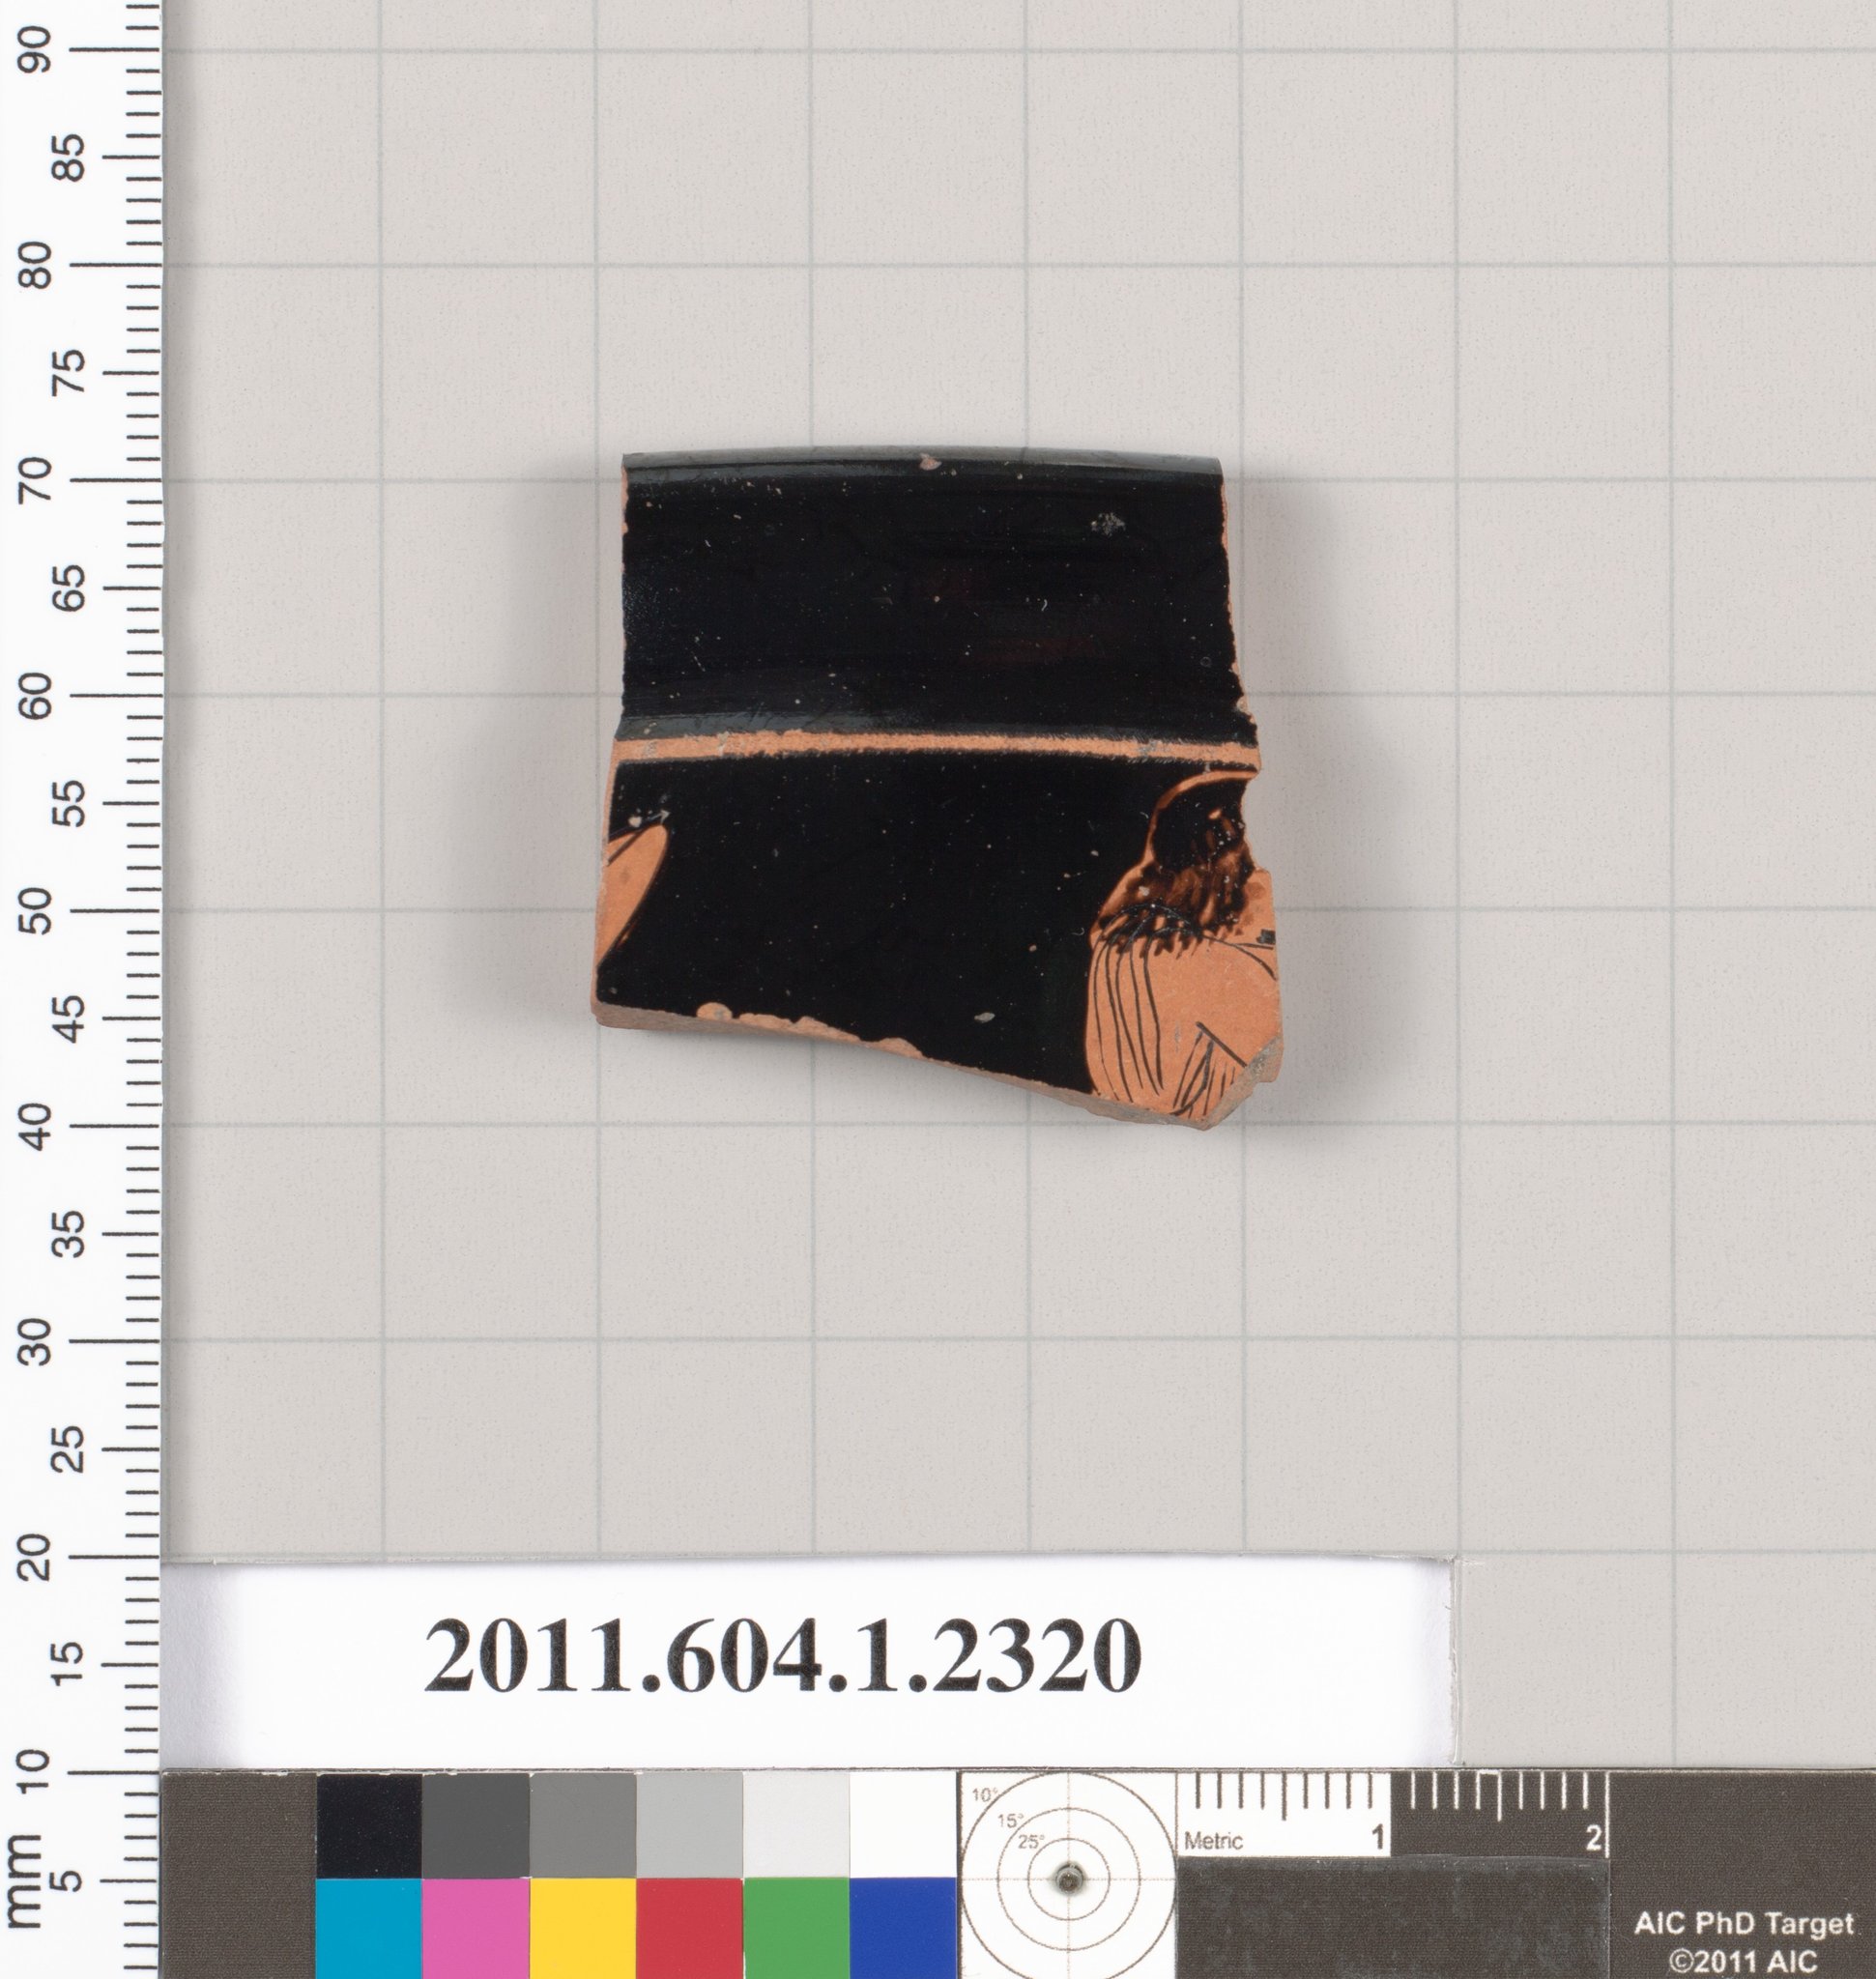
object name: kylix fragment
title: Terracotta rim fragment of a kylix (drinking cup)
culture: greek, attic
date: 475-451 BCE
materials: terracotta